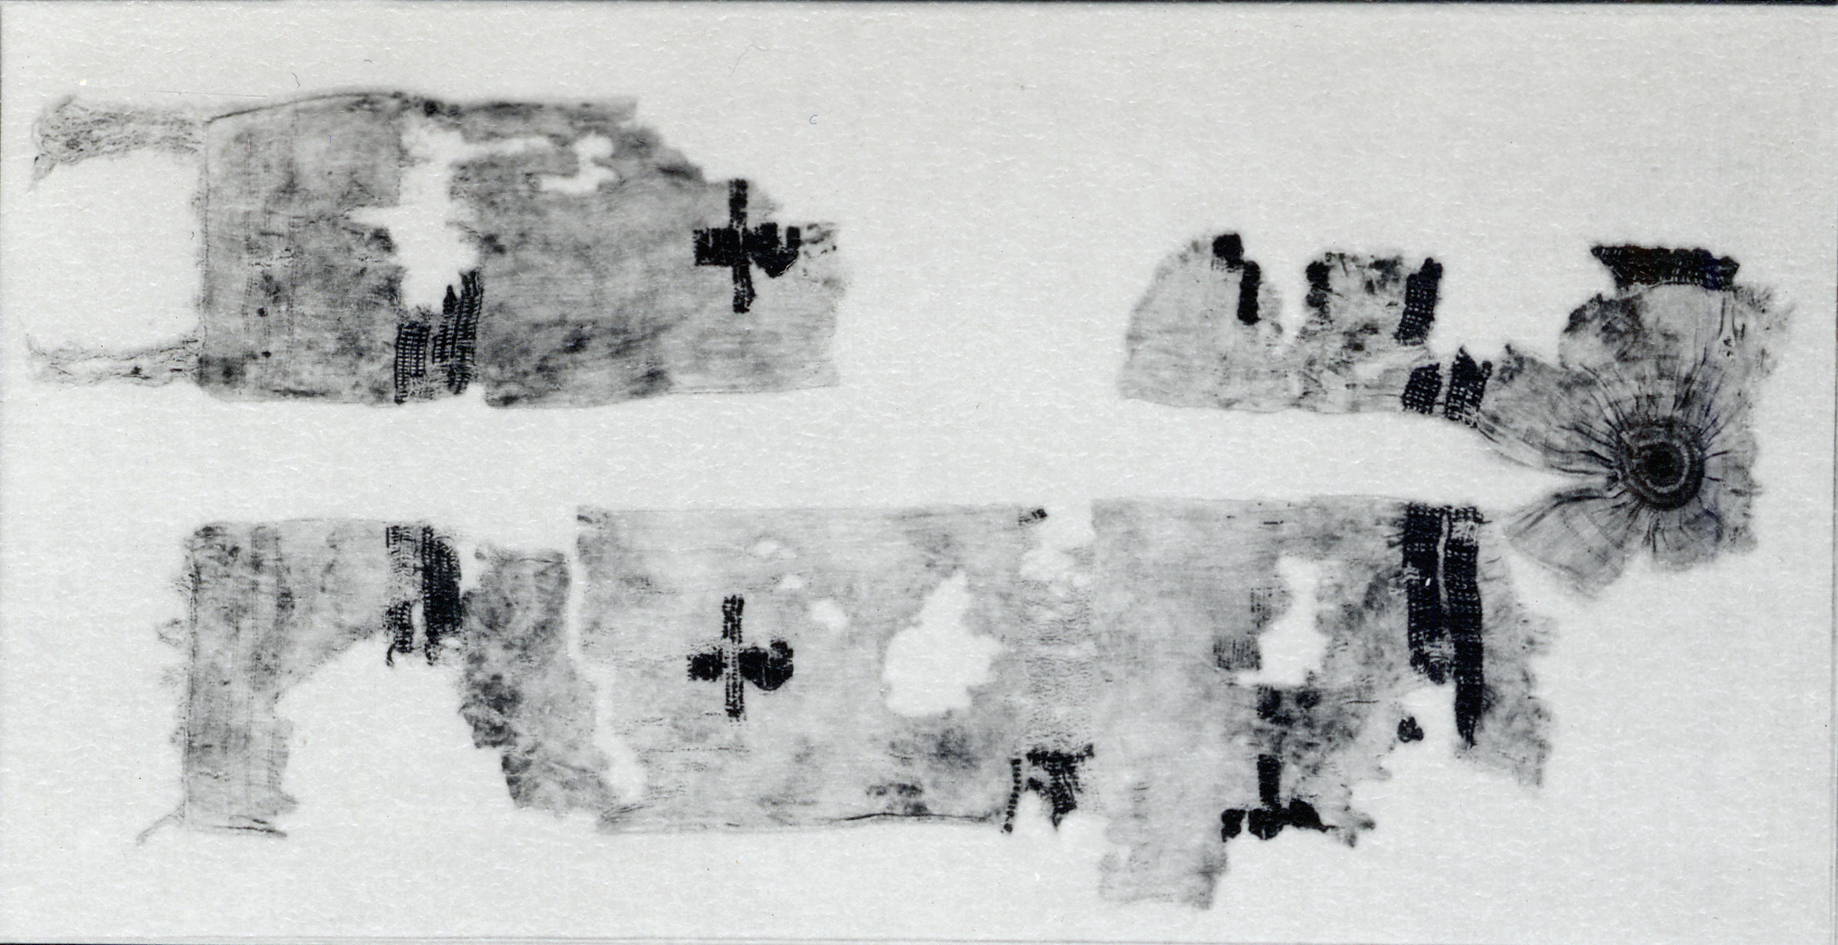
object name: fragment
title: Hat Fragments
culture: coptic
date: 301-400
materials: linen, wool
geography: egypt